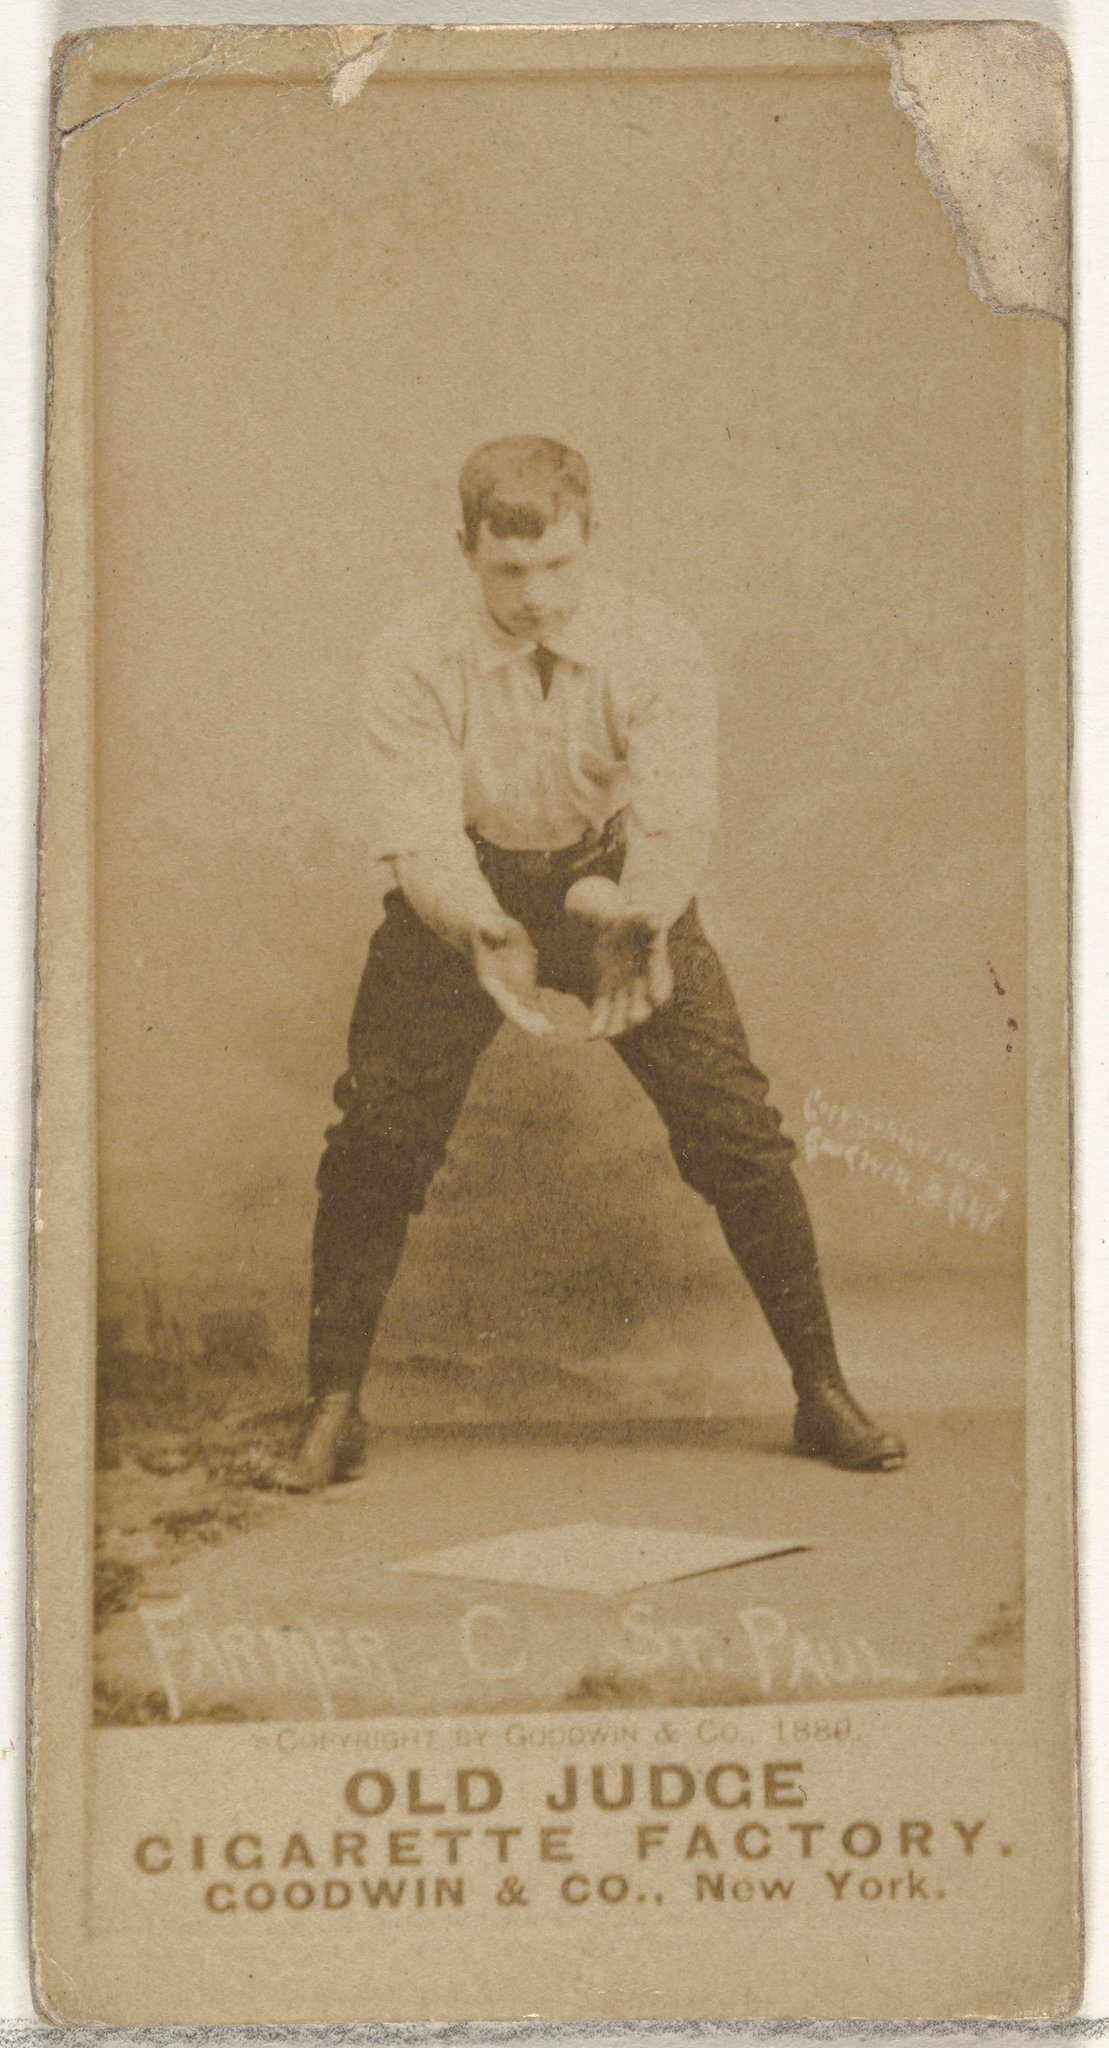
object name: baseball card, photograph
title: William Charles "Bill" Farmer, Catcher, St. Paul Apostles, from the Old Judge series (N172) for Old Judge Cigarettes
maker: goodwin & company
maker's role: publisher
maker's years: 1850-1950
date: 1889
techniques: albumen silver print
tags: men,portraits,baseball,athletes